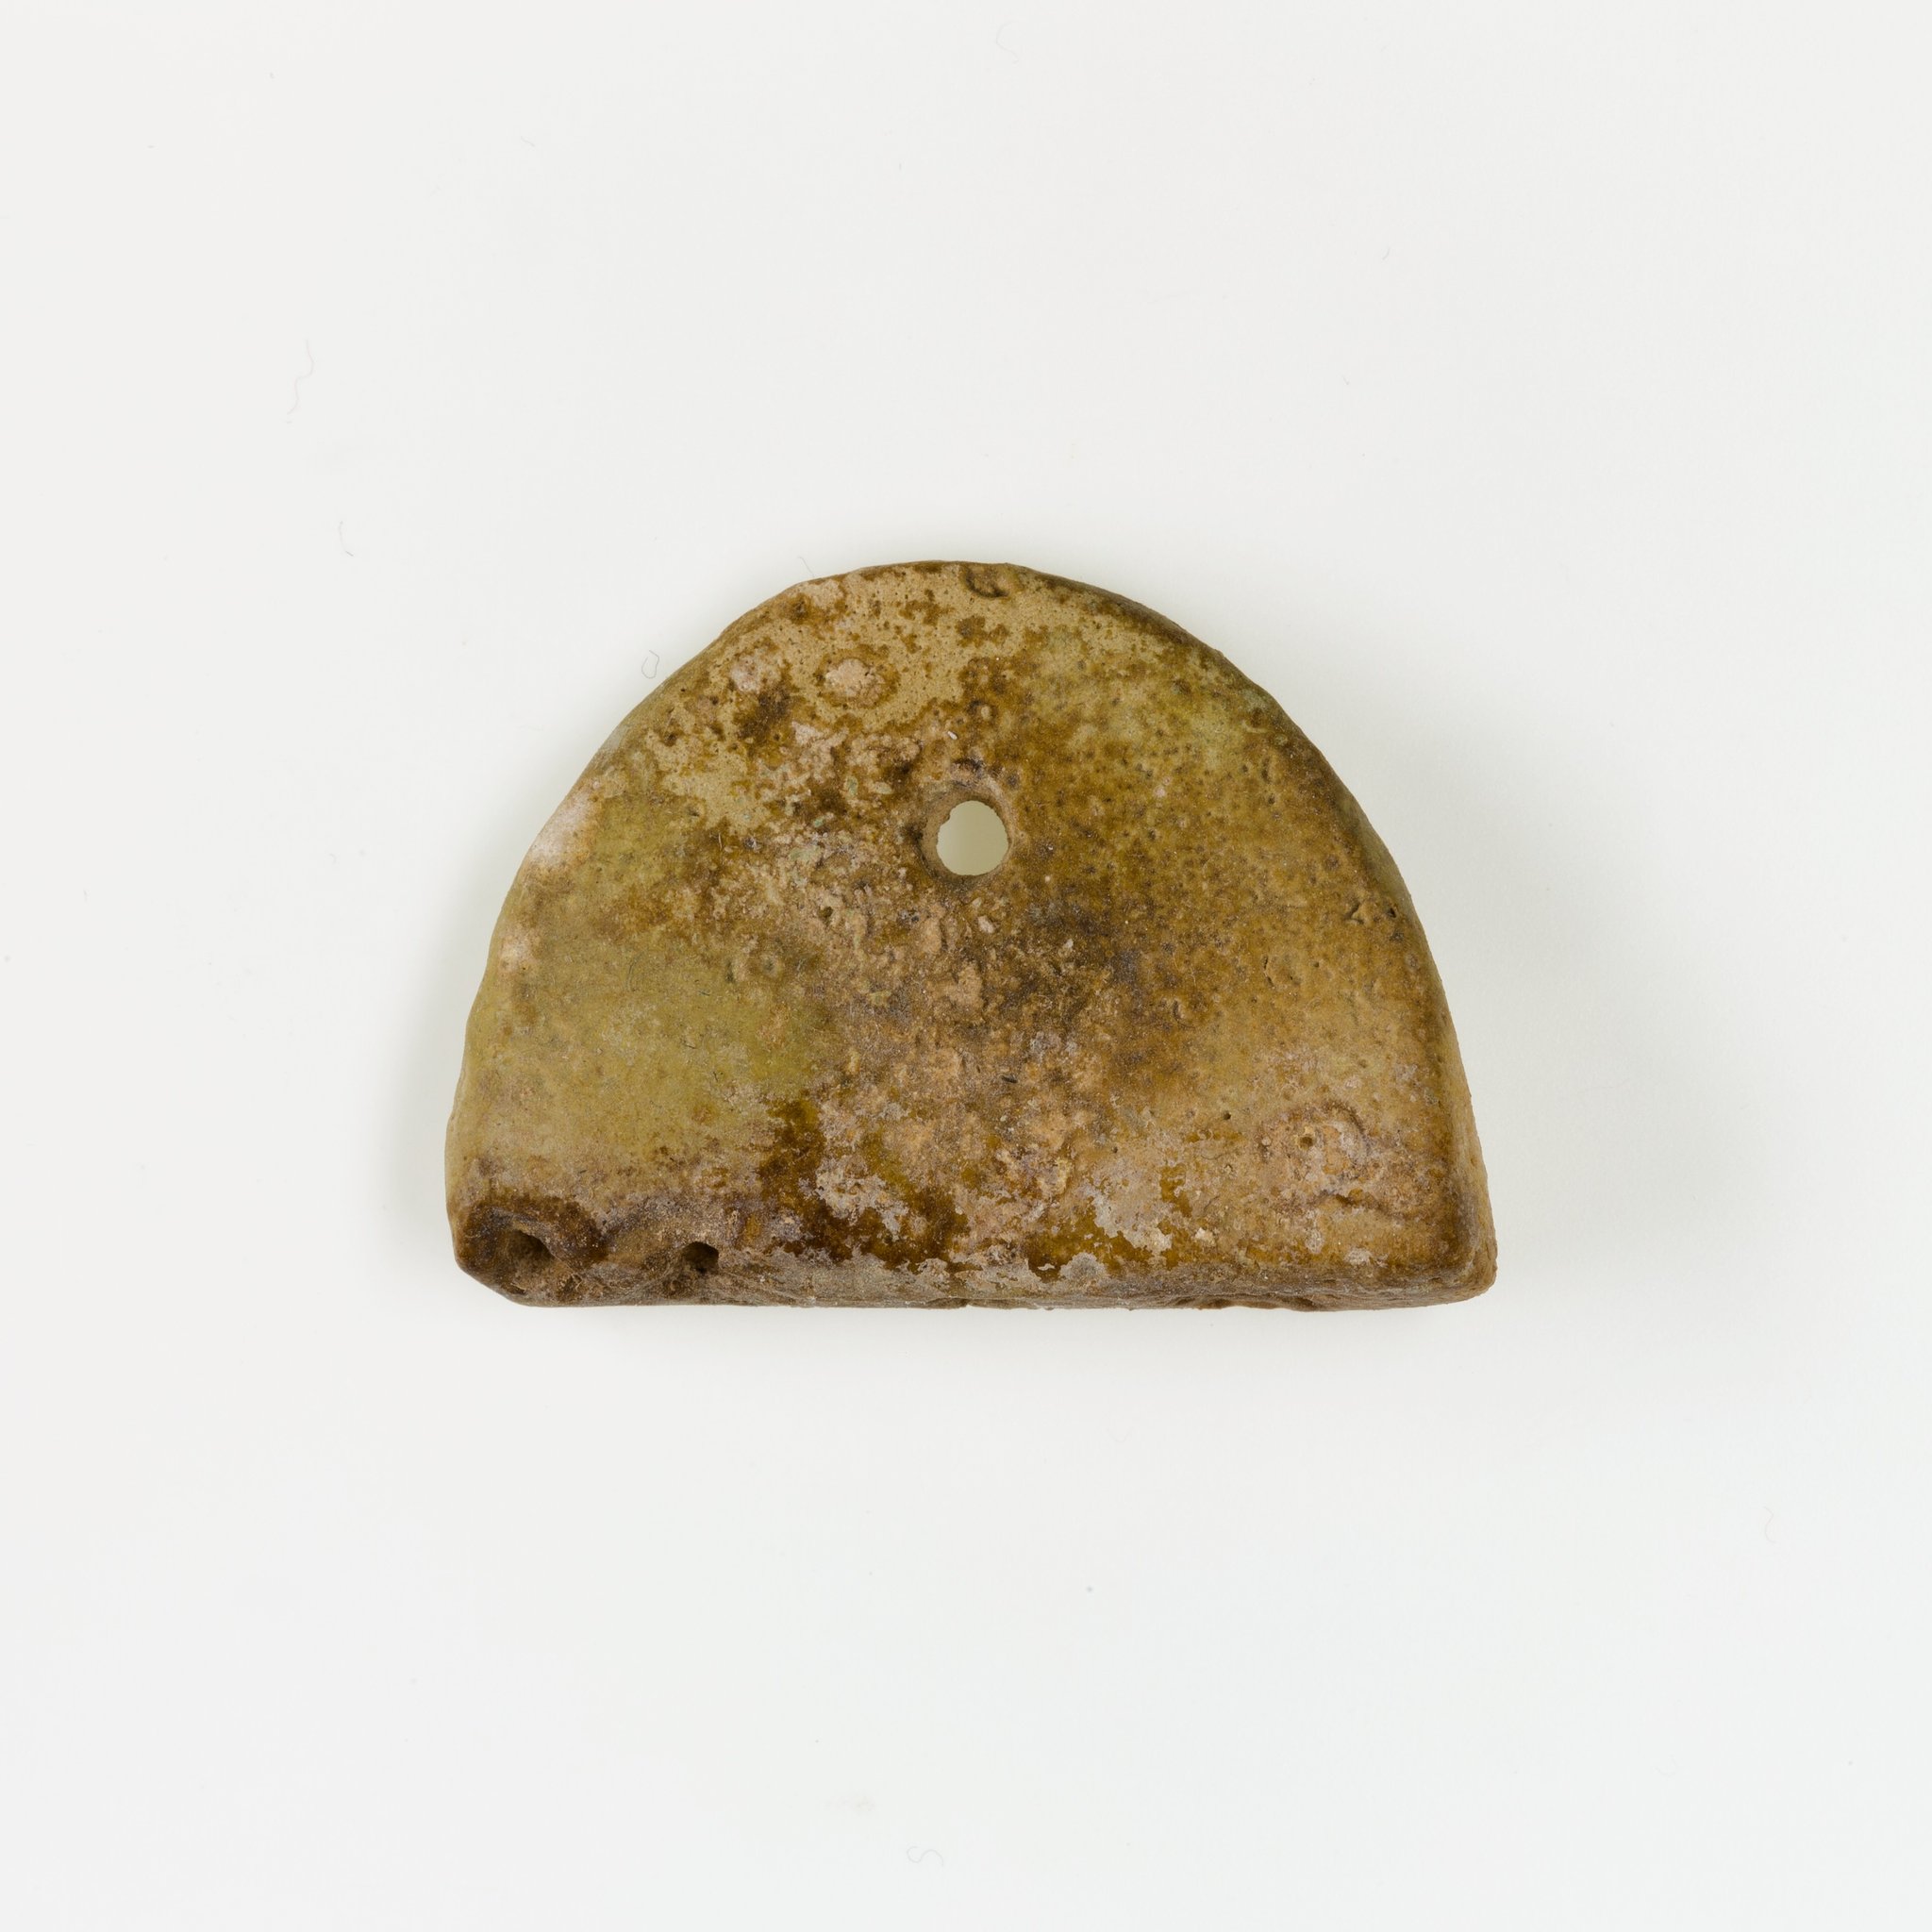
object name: broad collar piece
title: Broad Collar piece (?)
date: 1850-1640 BCE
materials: faience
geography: egypt